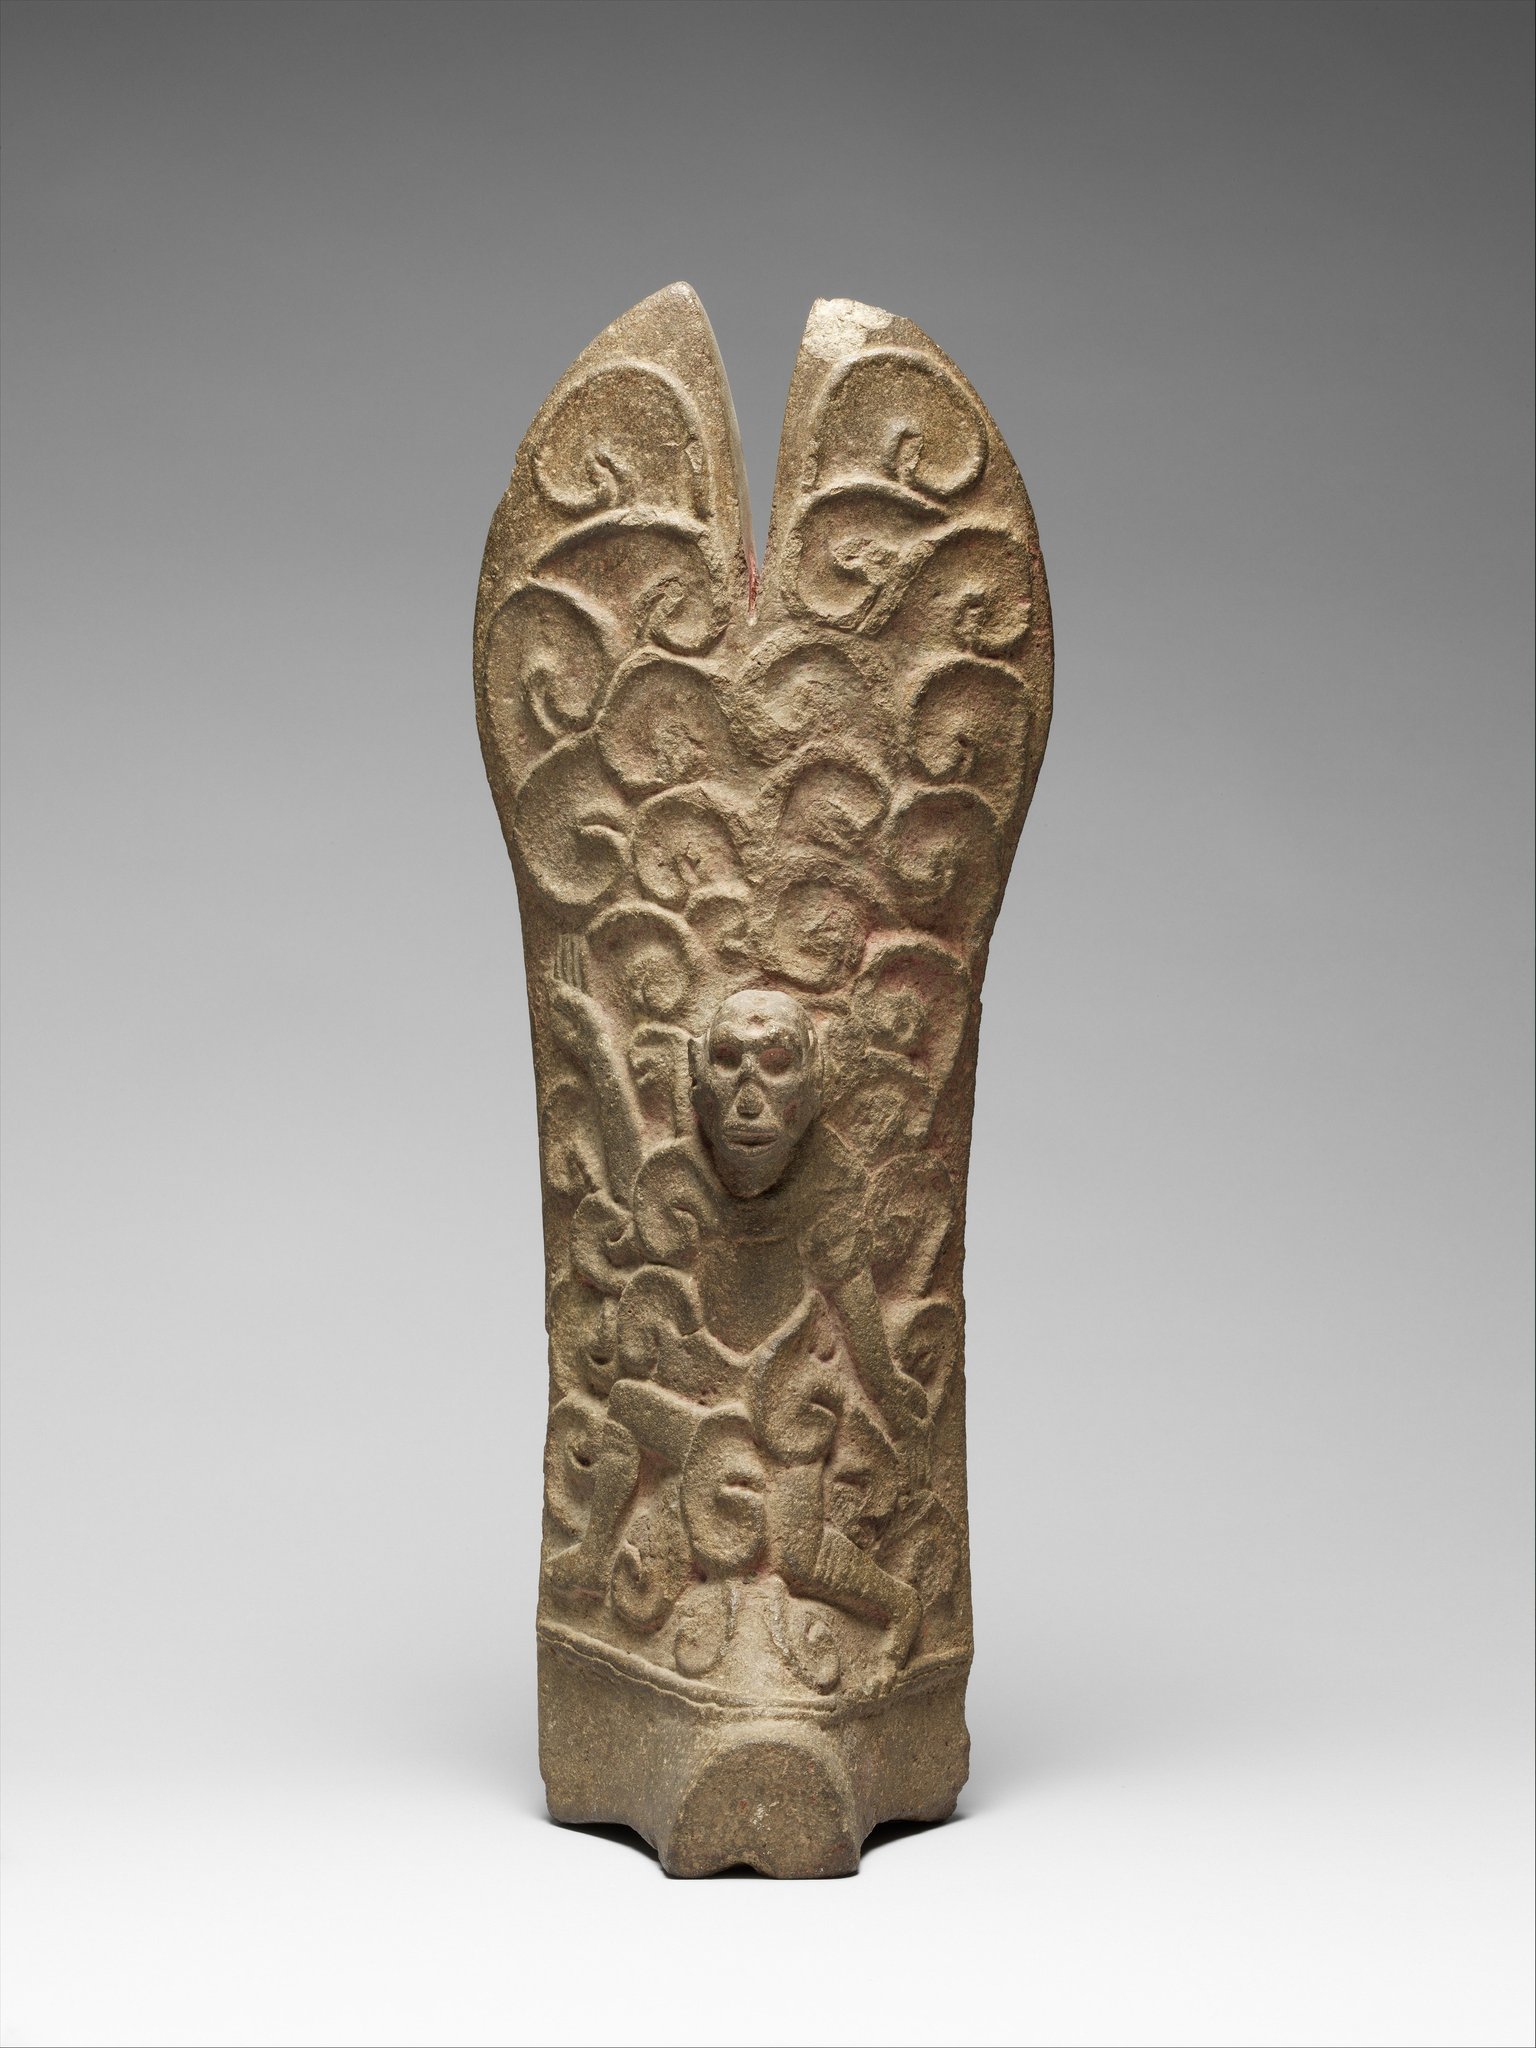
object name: palma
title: Palma with figure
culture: classic veracruz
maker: classic veracruz artist(s)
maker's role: artist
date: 800-1100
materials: pigment, stone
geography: mexico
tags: human figures